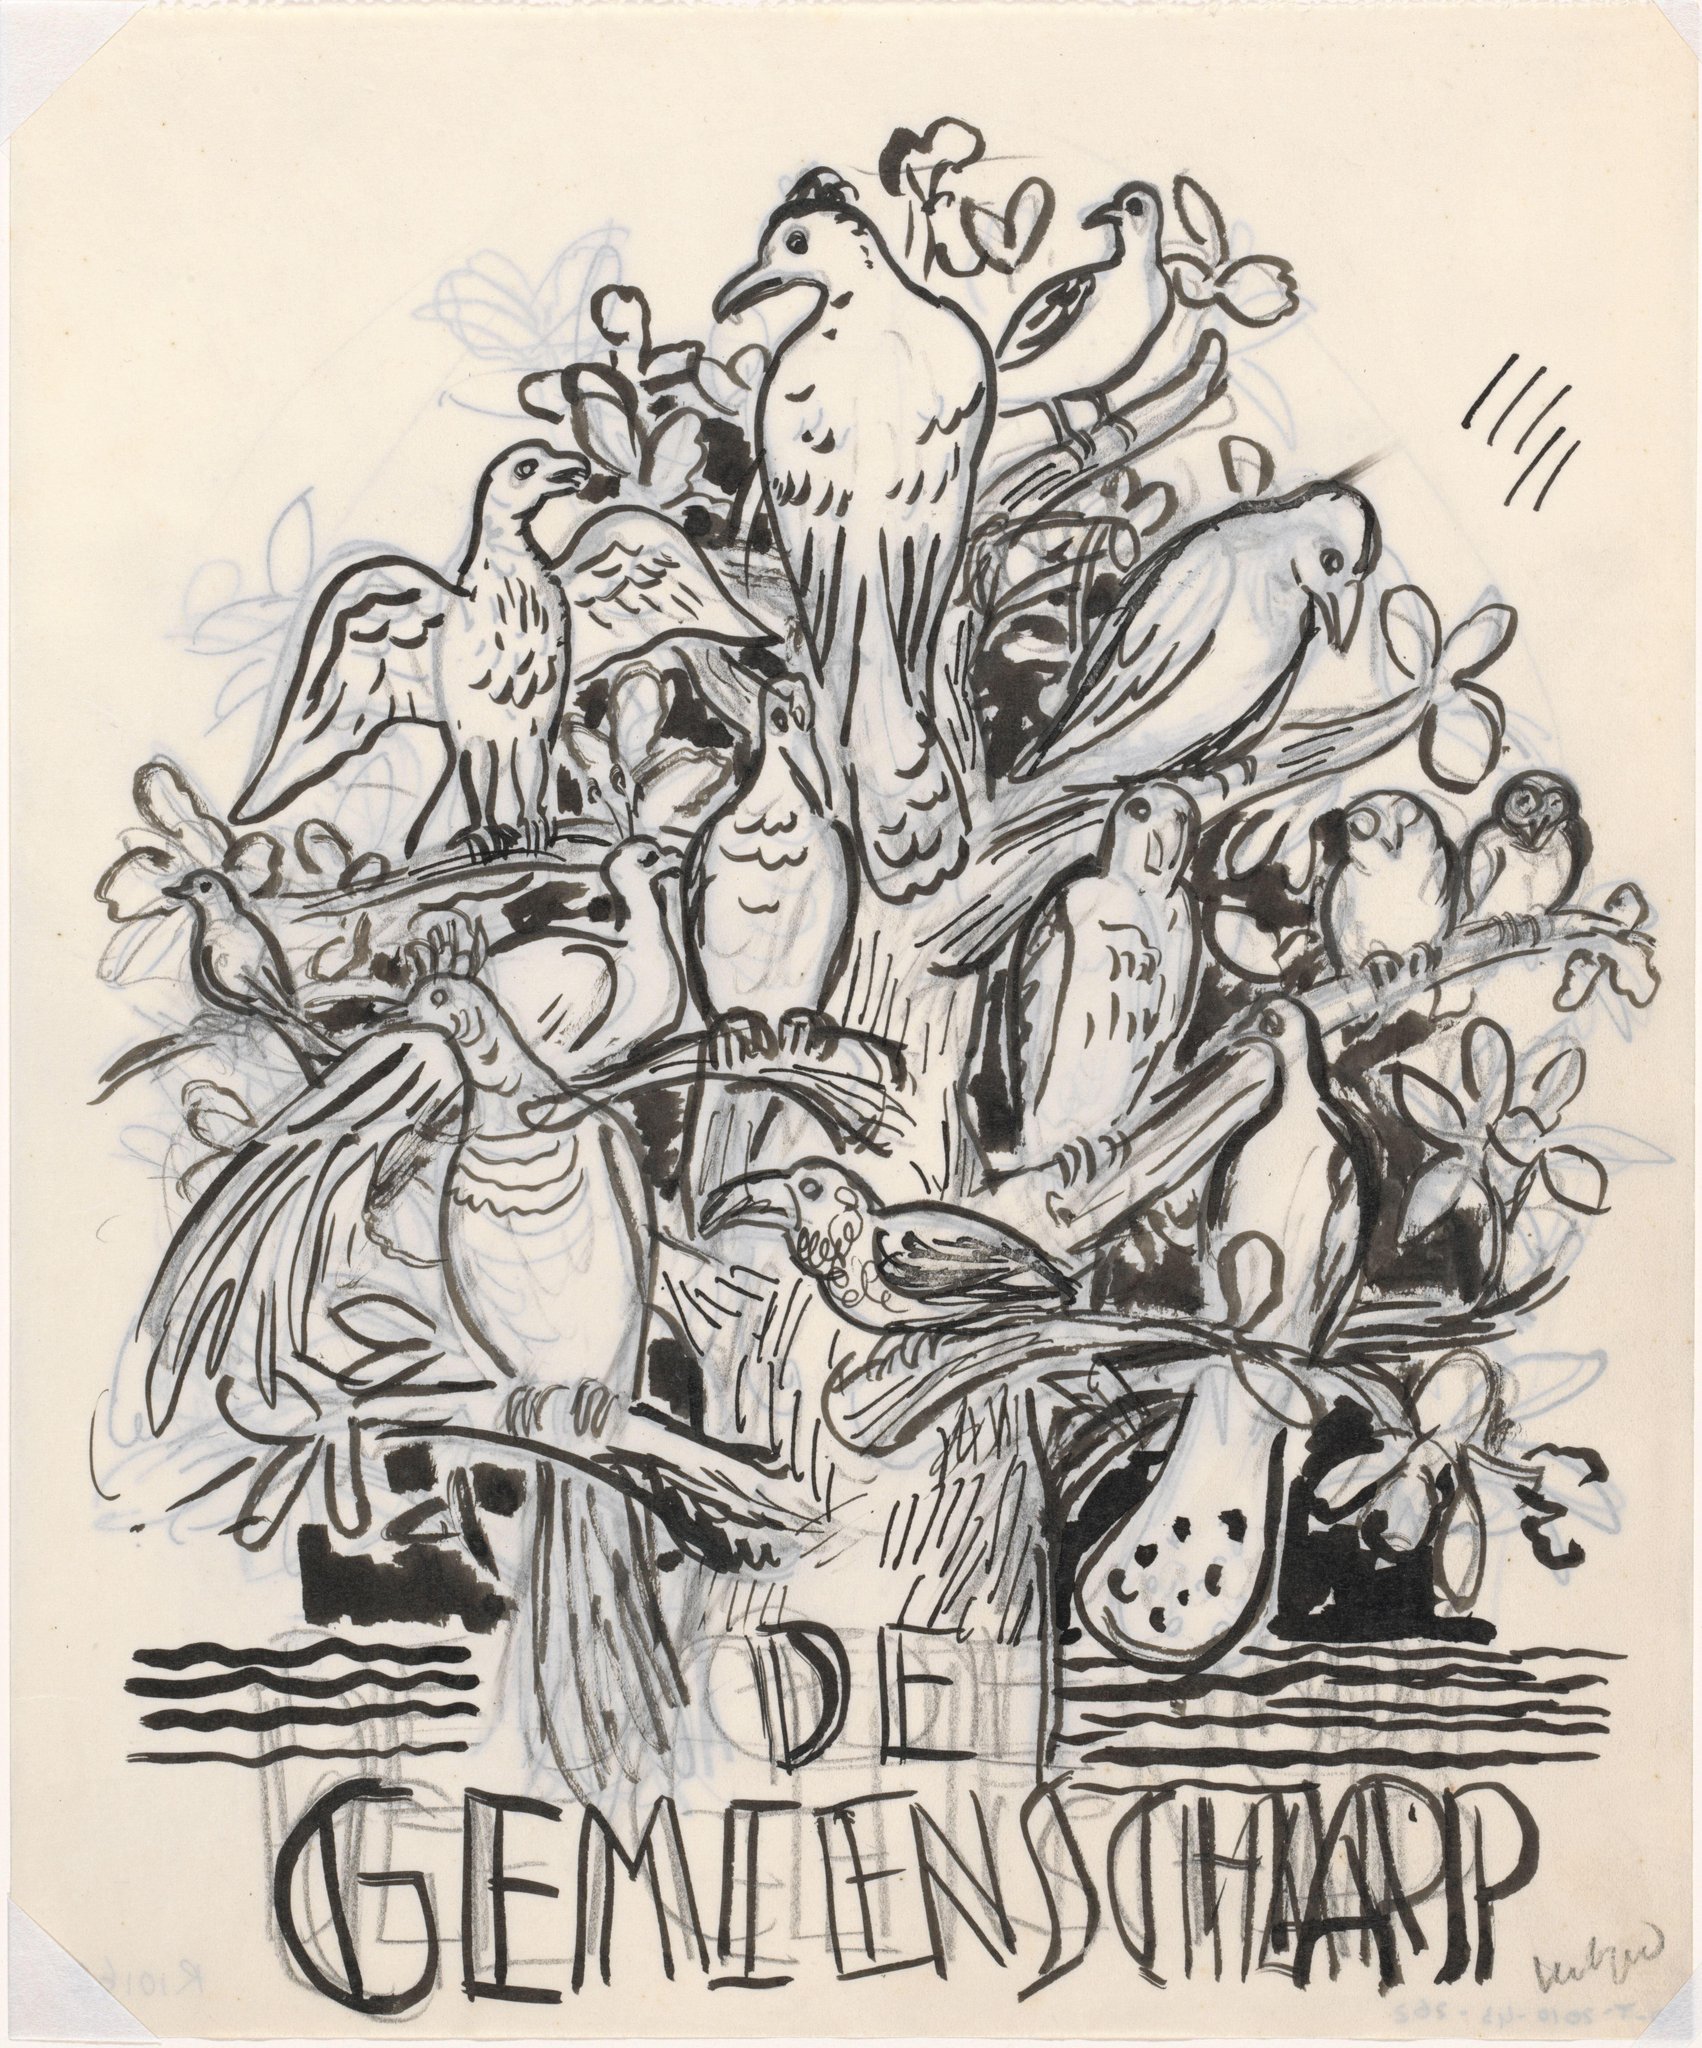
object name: drawing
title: Boom met vogels (omslagontwerp voor De Gemeenschap)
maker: leo gestel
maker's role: draughtsman, print maker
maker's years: 1881-1941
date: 1935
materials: ink, paper, pencil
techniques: brush, pen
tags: birds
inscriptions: inscription: ‘DE / GEMEENSCHAP’, inscription: ‘Uitgev.’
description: Omslagontwerp voor De Gemeenschap: Boom met diverse vogels, o.a. uilen, pauw, duif en toekan.